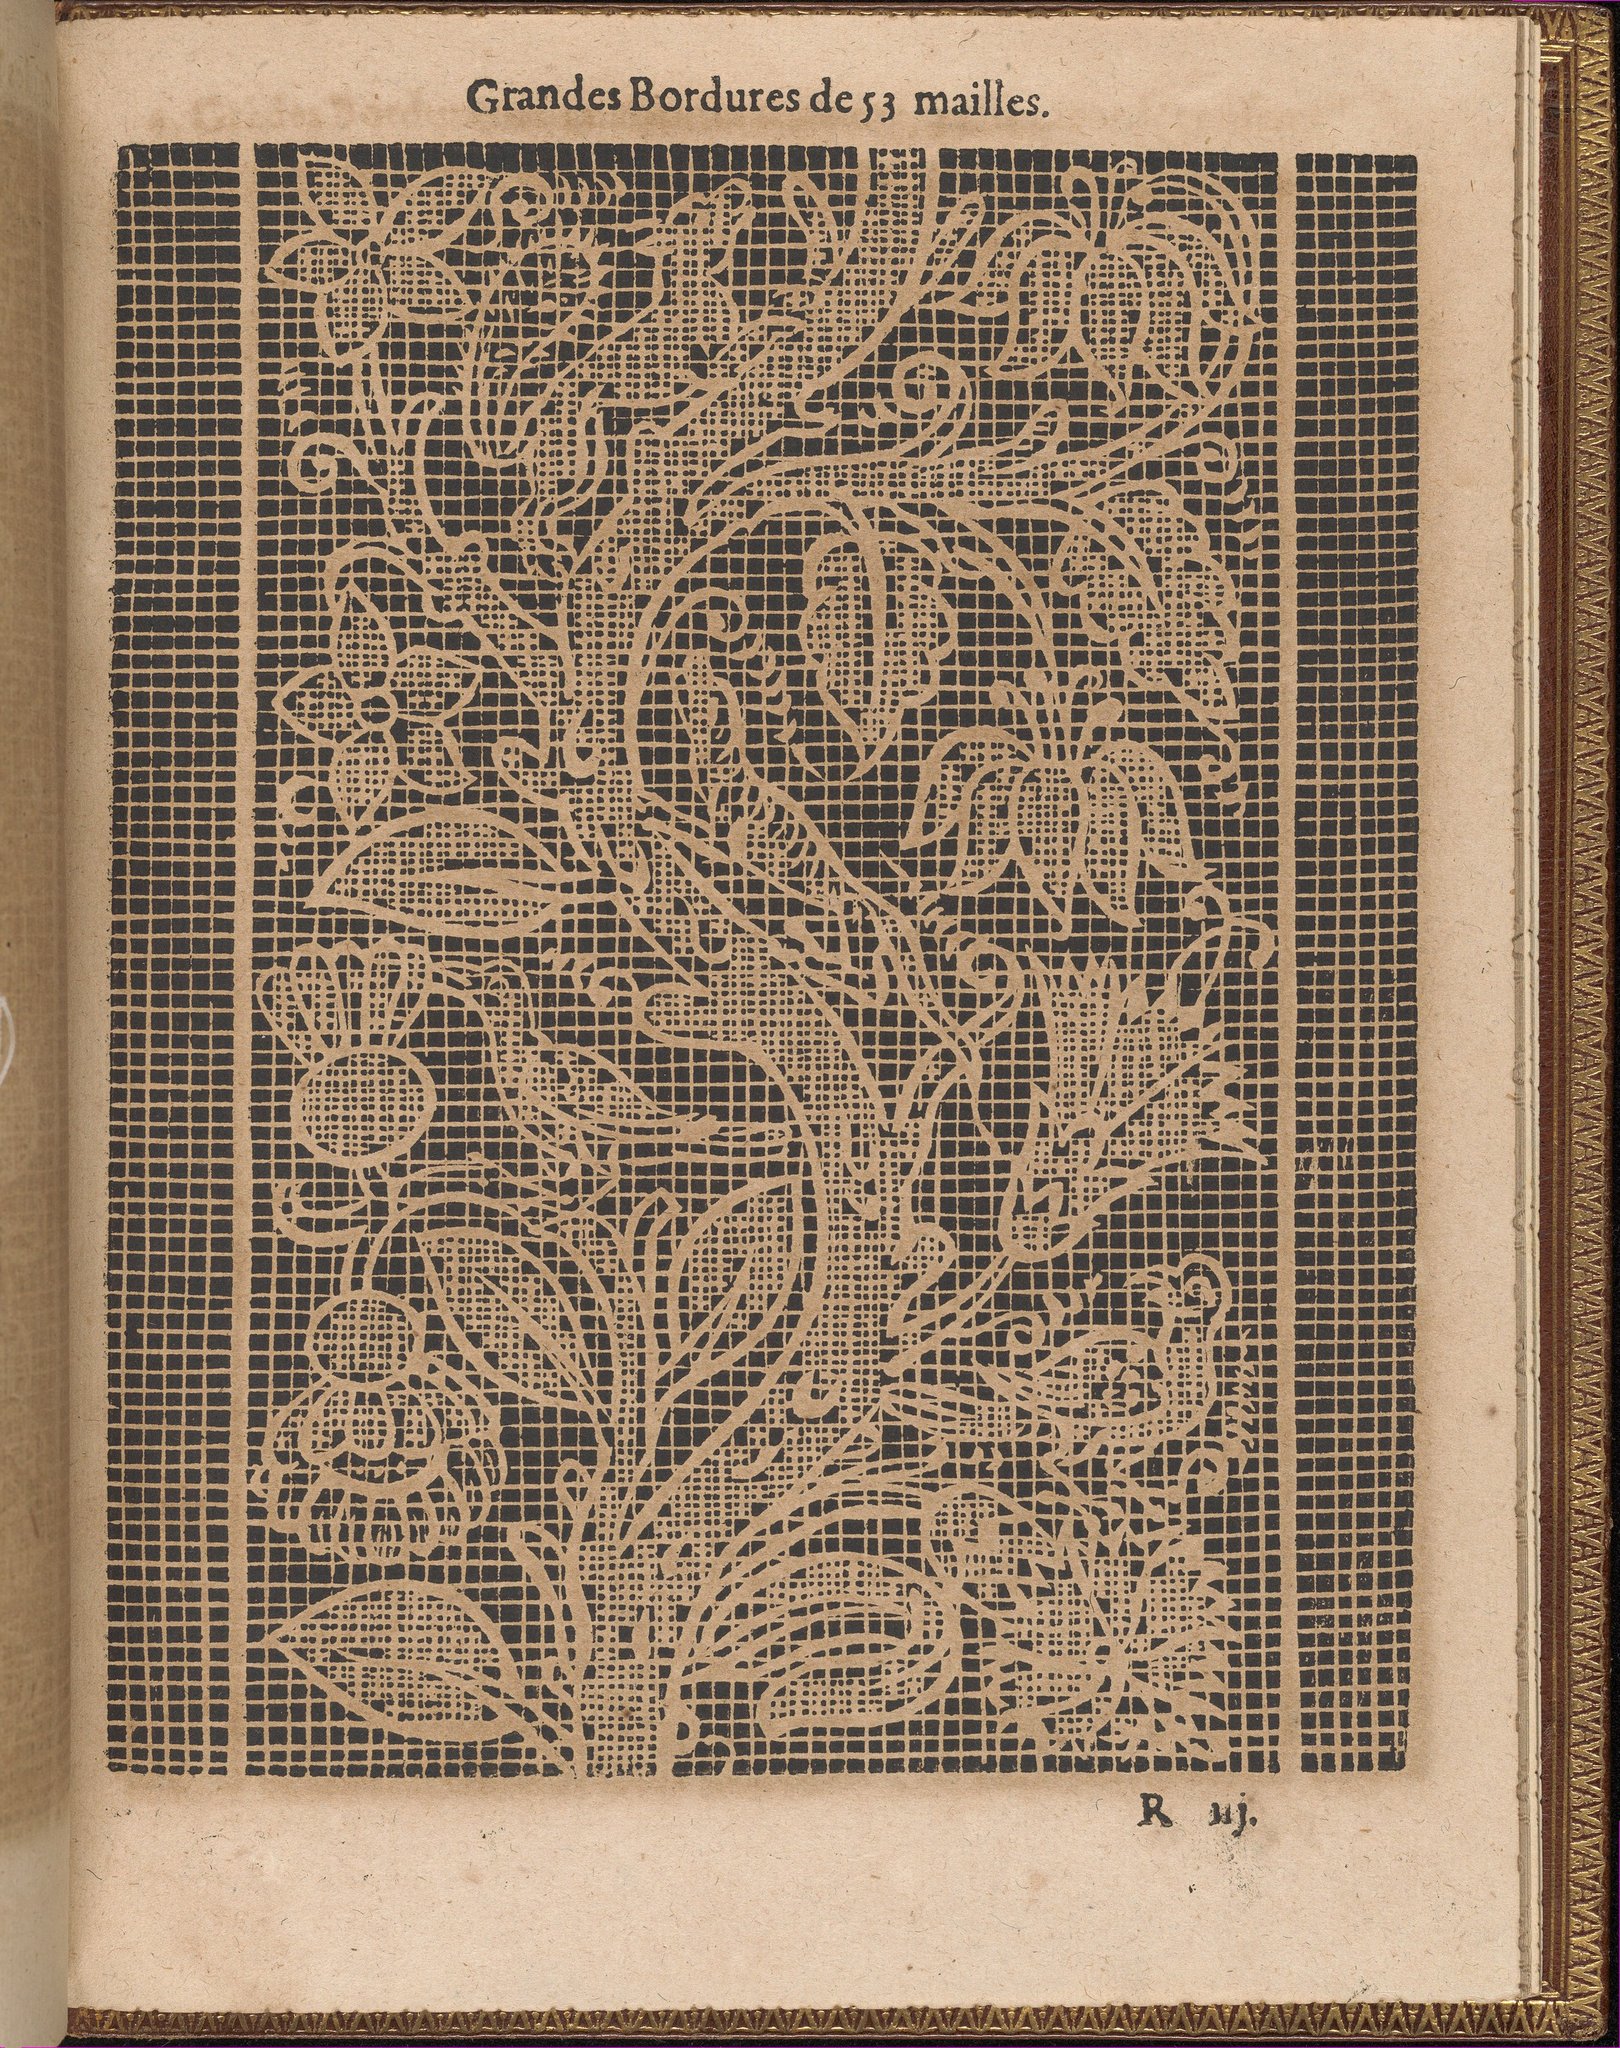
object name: book print ornament architecture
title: La Pratique de l'Aiguille, page 66 (recto)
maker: matthias mignerak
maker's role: author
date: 1605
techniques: woodcut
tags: birds,squirrels,flowers,vines